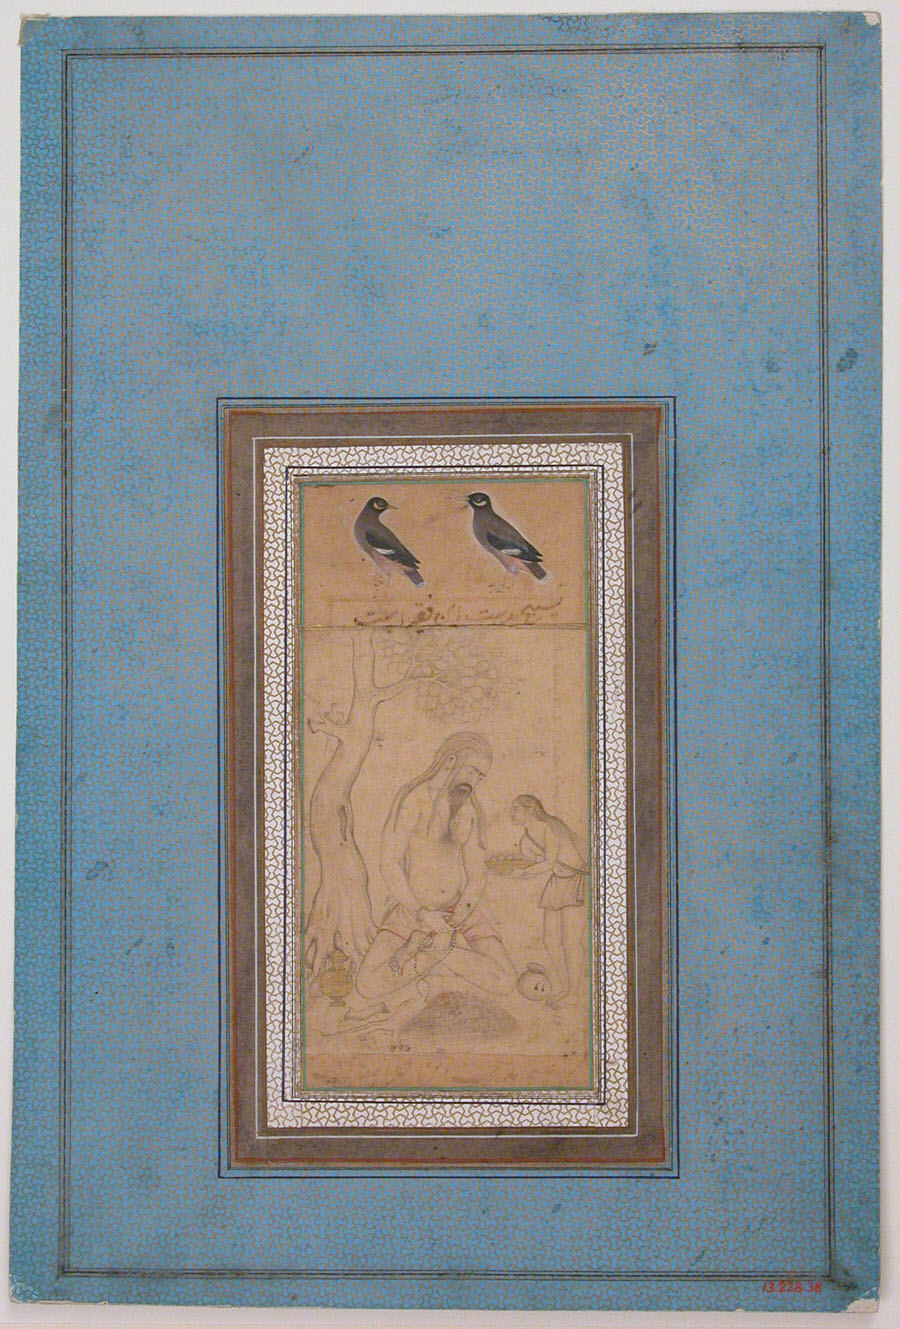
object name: illustrated album leaf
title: Holy Man (Faqir or Sadhu)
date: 1801-1900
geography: india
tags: birds,men,trees